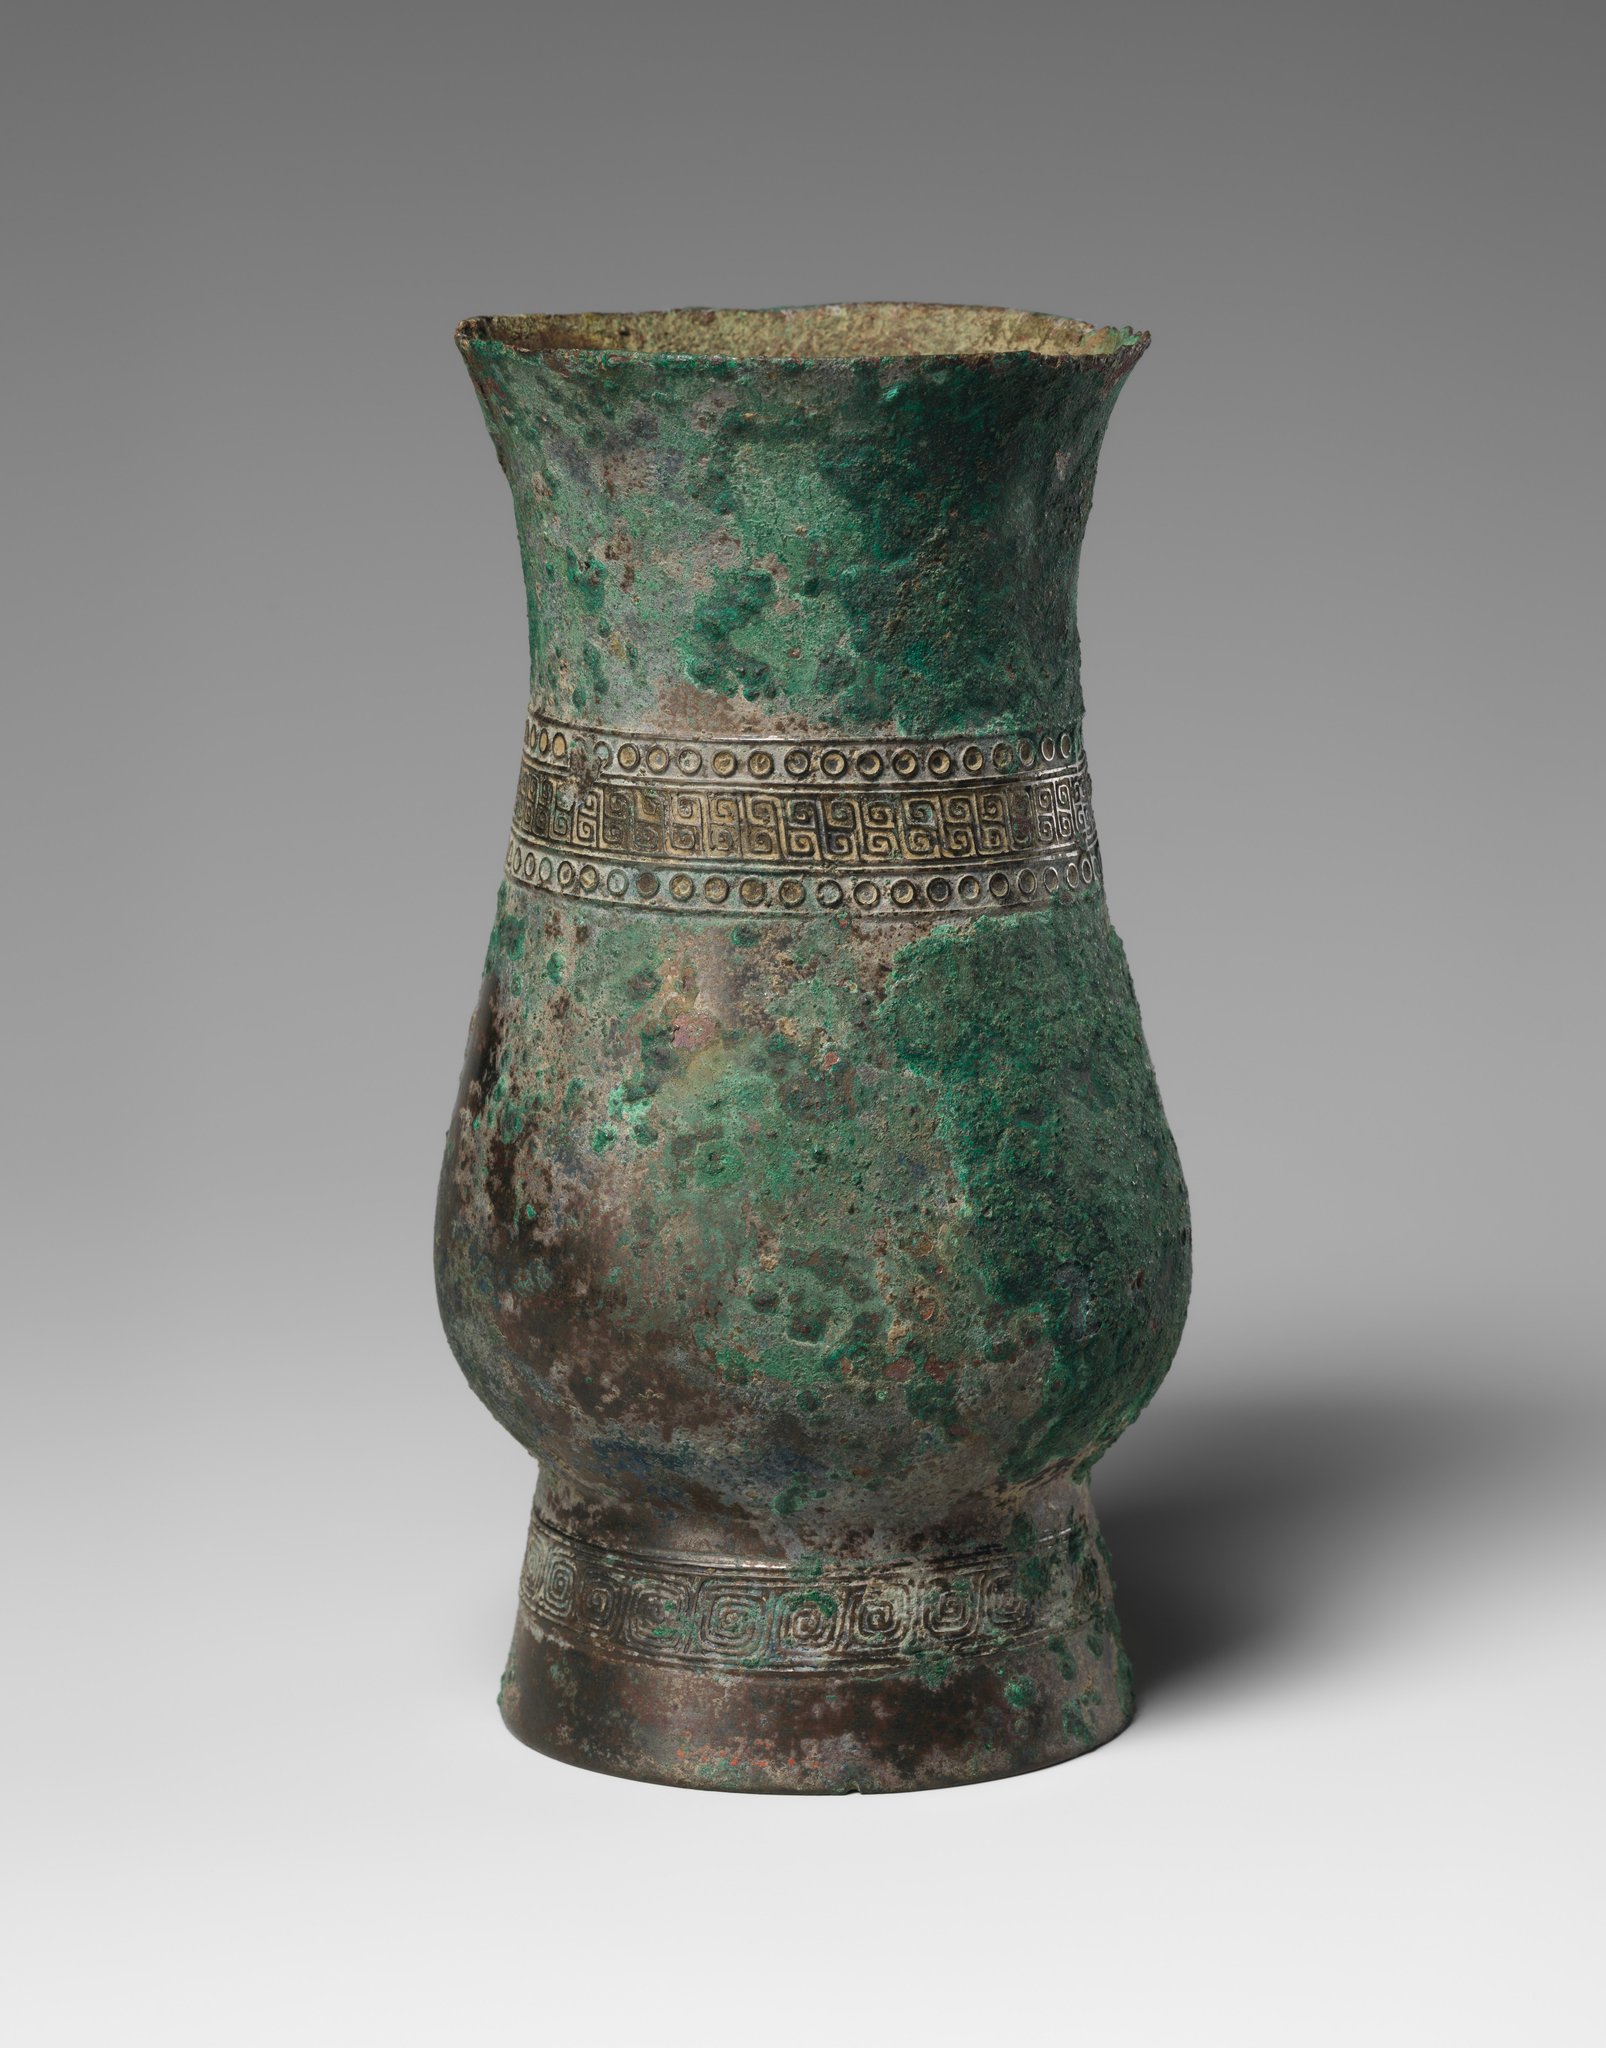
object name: wine cup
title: Ritual Wine Cup (Zhi)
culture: chinese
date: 1034-1001 BCE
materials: bronze